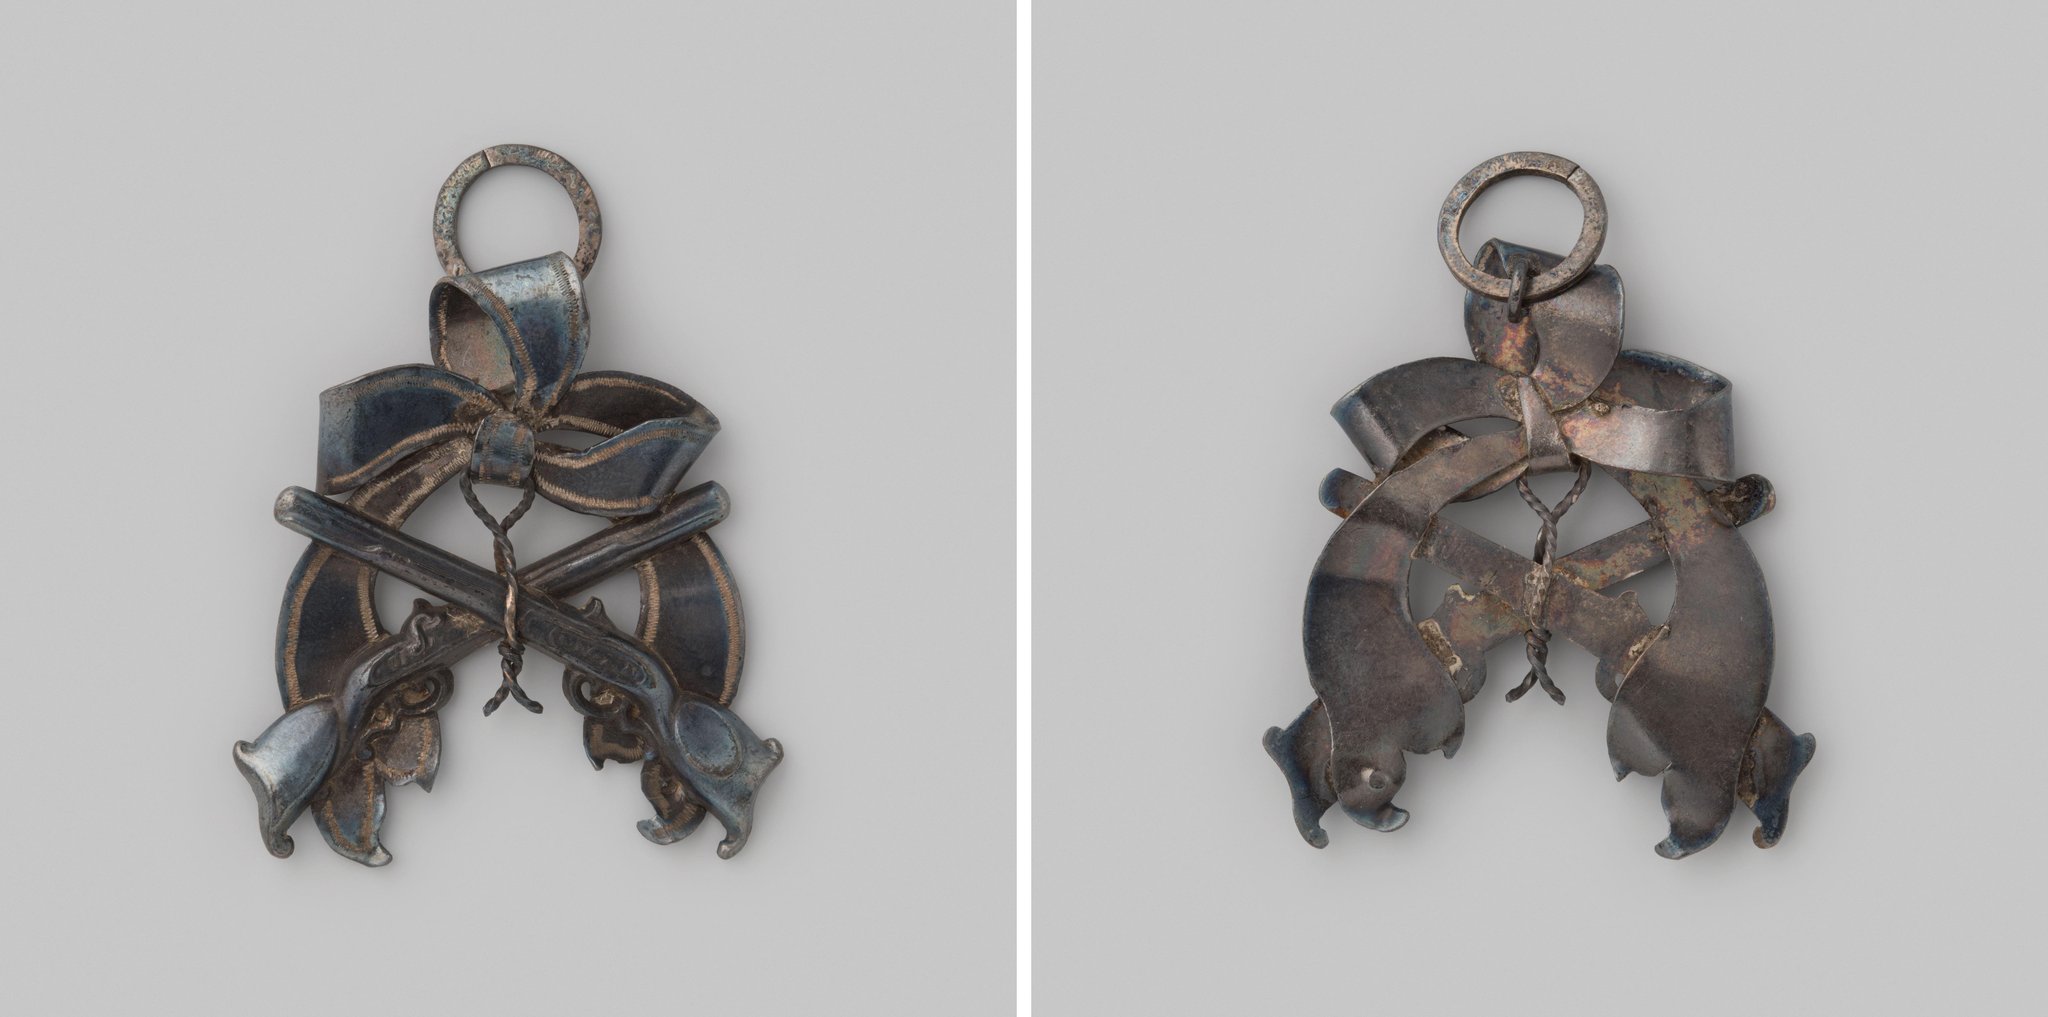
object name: insignia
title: Draagteken van twee samengebonden geweren op een gestrikt lint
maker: Anonymous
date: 1800-1949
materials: metal